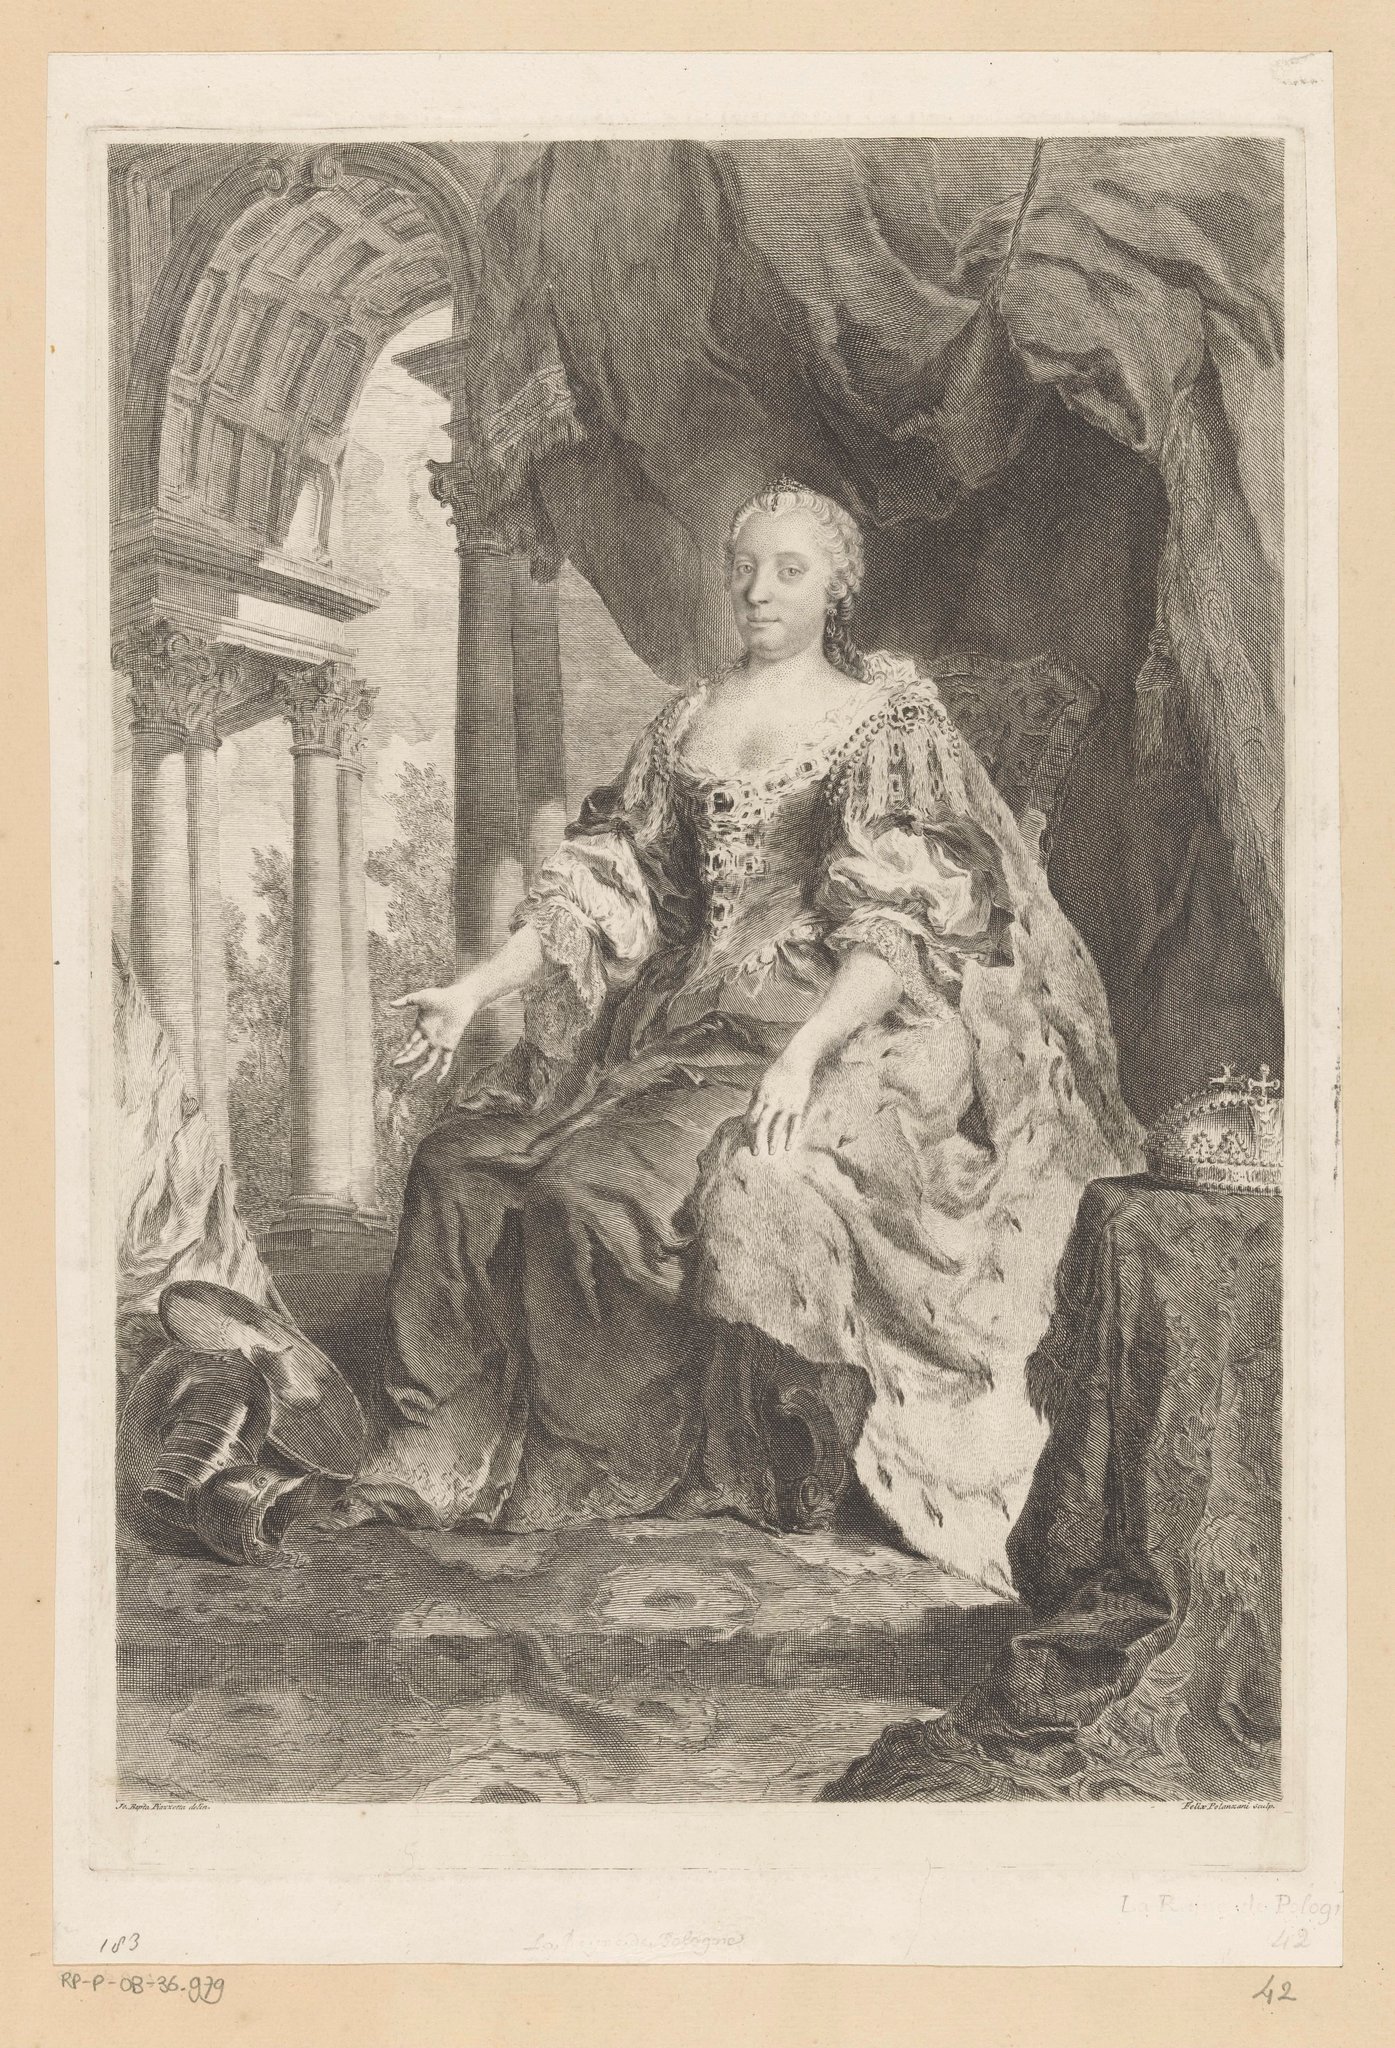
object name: print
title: Portret van Catharina de Grote, tsarina van Rusland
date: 1710-1783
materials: paper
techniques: etching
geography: italy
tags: catharina de grote, historical persons, ruler, sovereign - bb - female ruler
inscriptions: collector's mark: Lugt 240